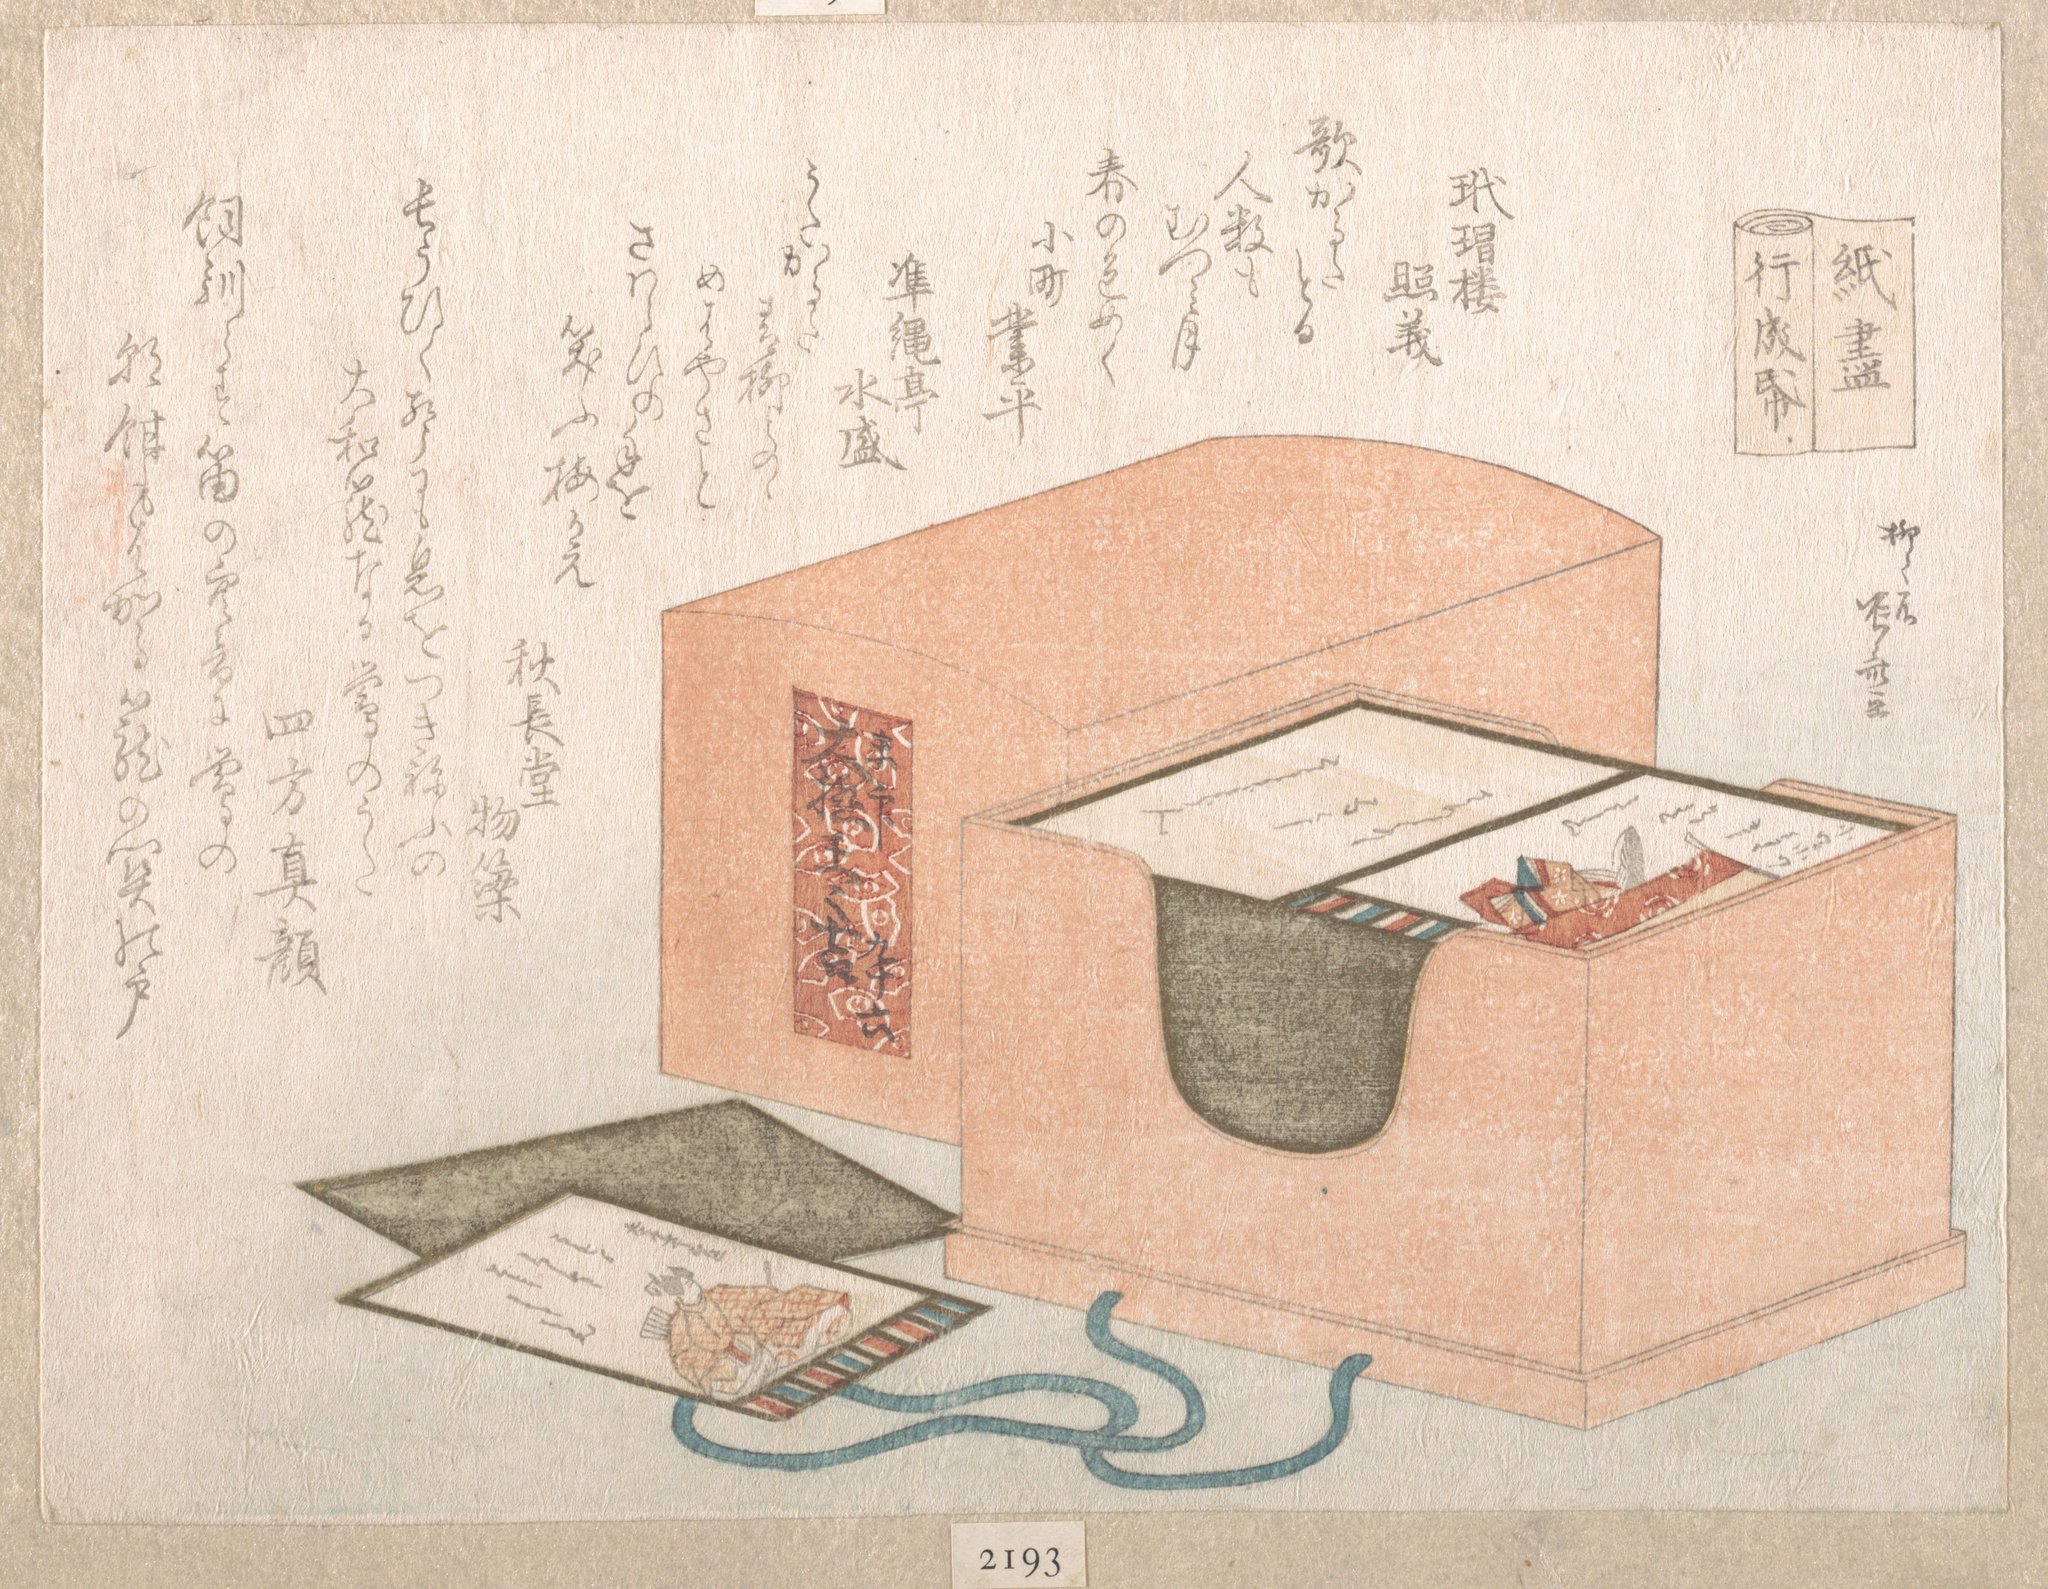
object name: woodblock print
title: Box with Cards for the Poem Card Game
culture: japanese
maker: ryūryūkyo shinsai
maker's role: artist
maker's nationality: japanese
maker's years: 1799-1823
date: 1750-1835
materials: ink, paper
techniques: surimono, woodblock print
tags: playing cards,games